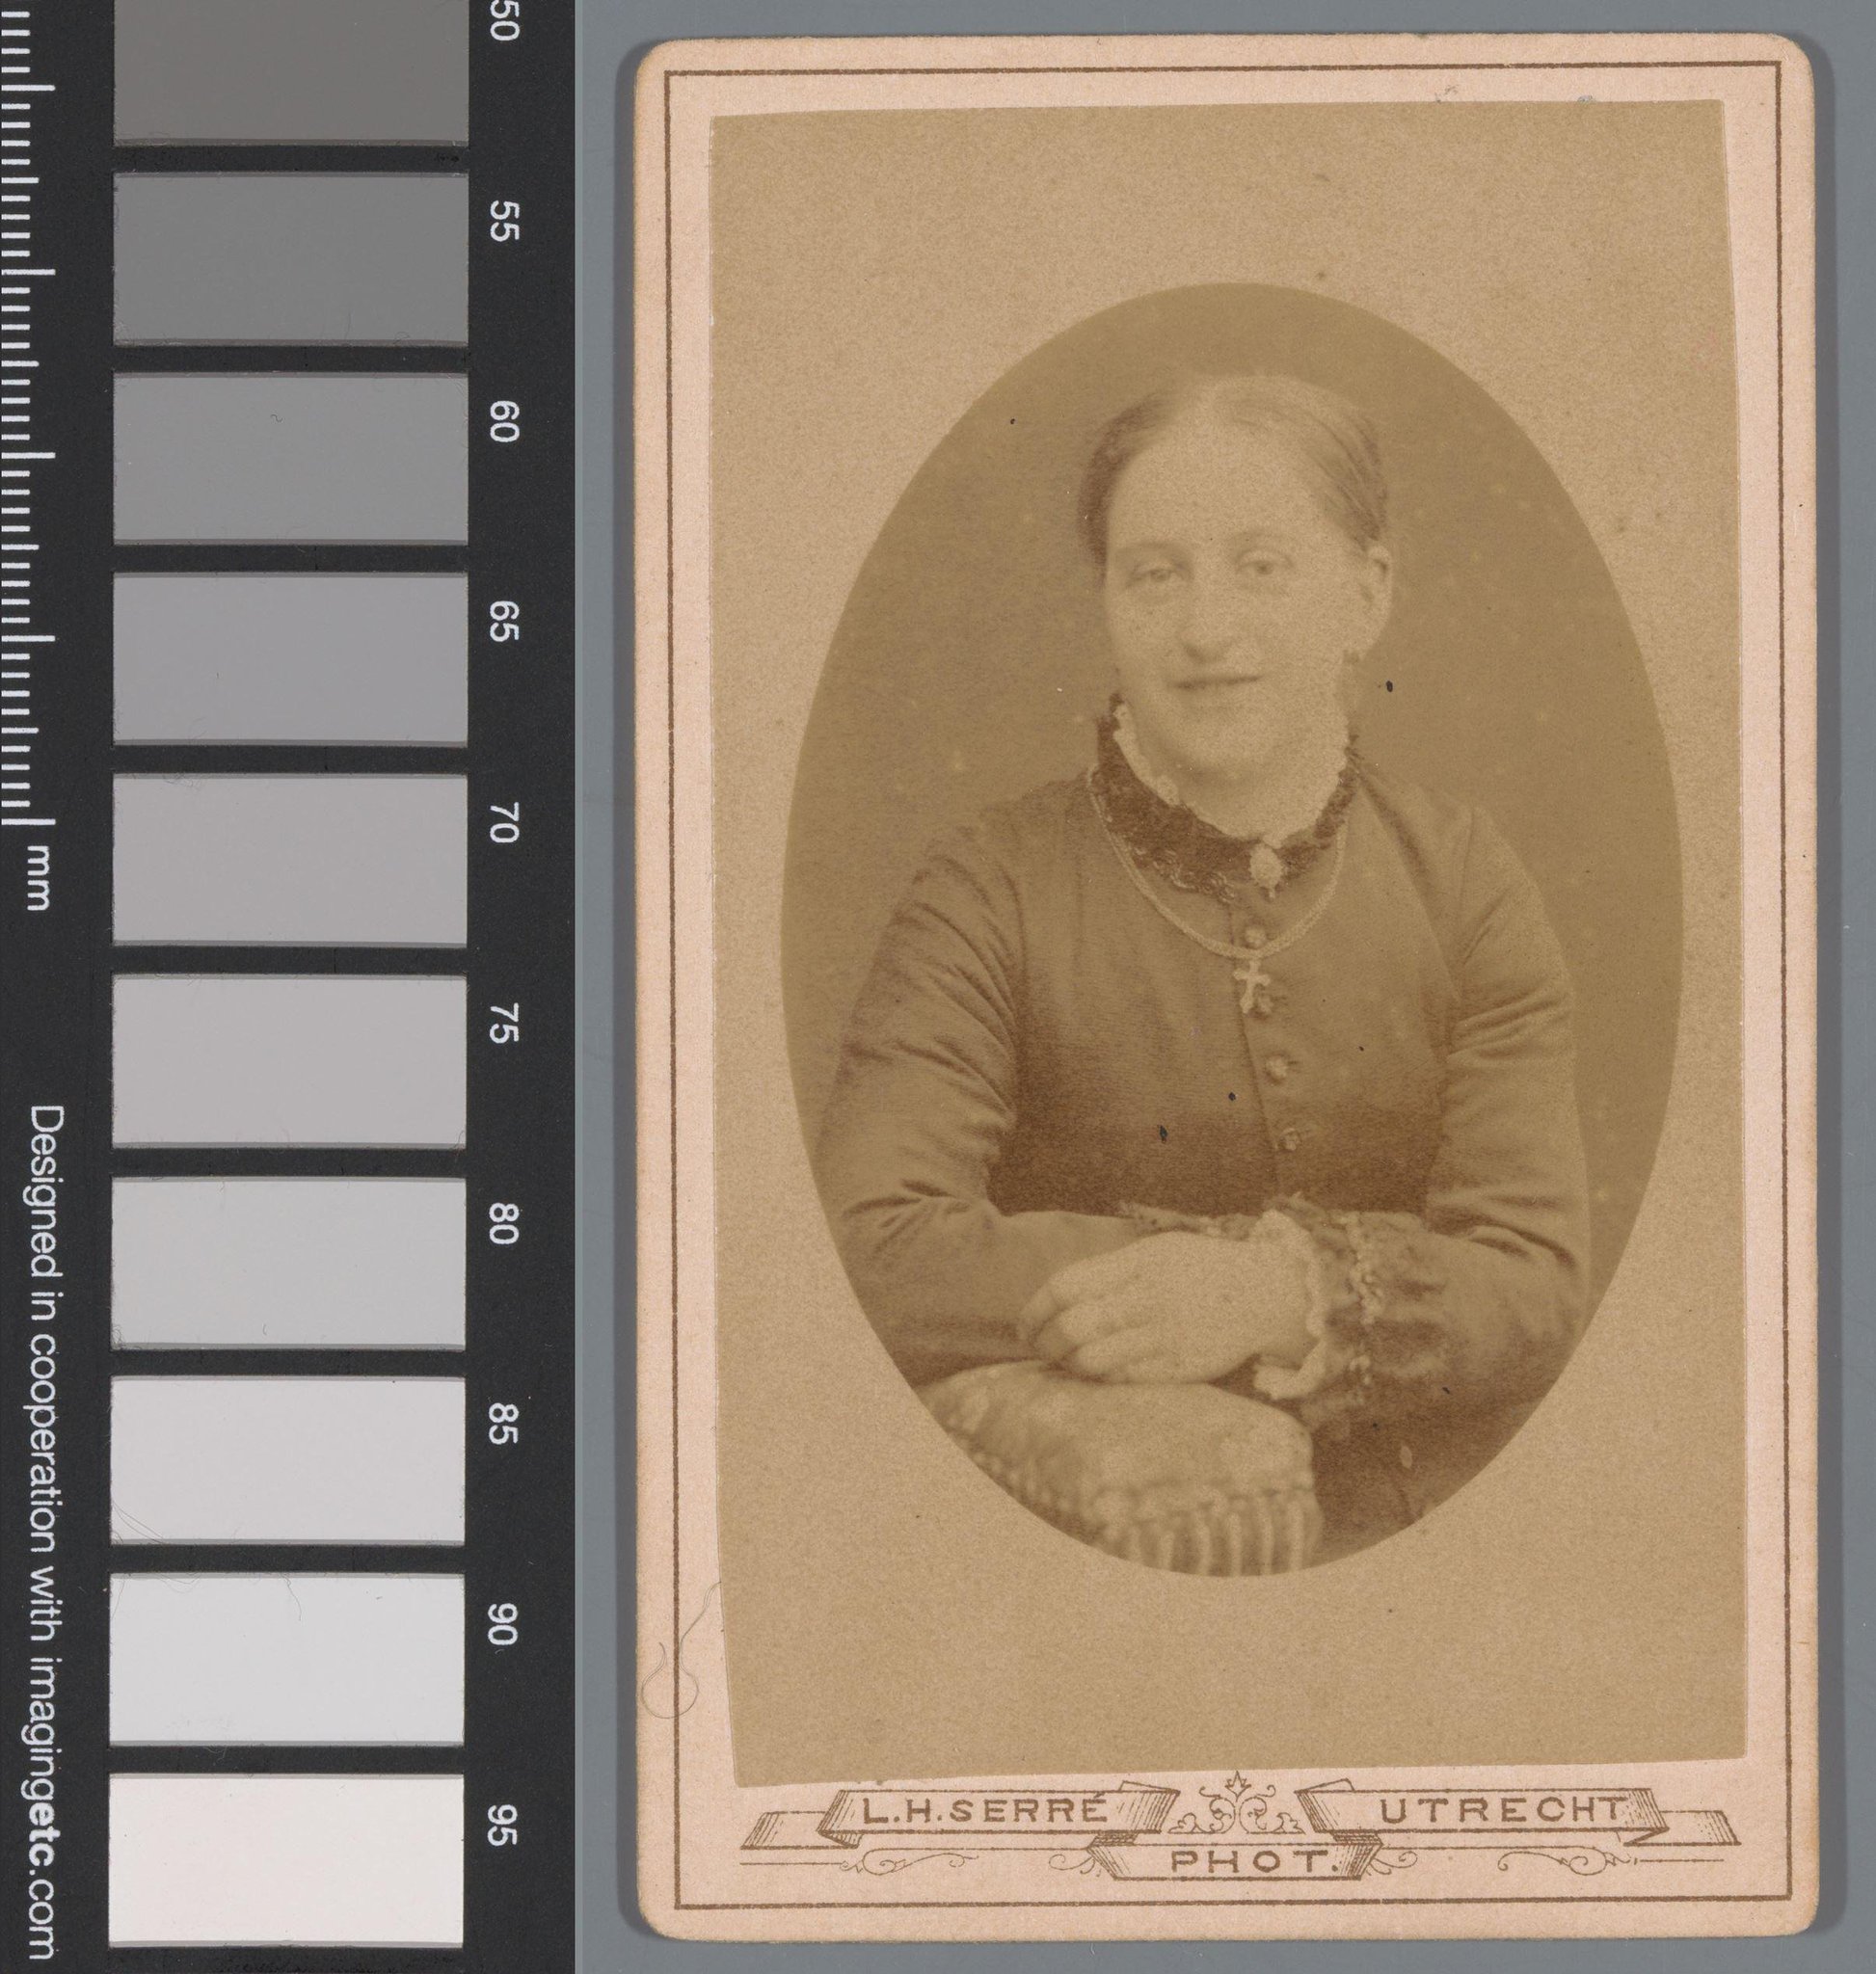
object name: photograph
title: Portret van een onbekende vrouw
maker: lodewijk hendrikus serré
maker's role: fotograaf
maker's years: 1847-1897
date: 1877-1897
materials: cardboard, paper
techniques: albumen print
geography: utrecht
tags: adult woman, anonymous historical person portrayed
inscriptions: address: ‘NACHTEGAALSTRAAT, over het Park Tivoli/ Utrecht/ 's Hage, Tiel en Arnhem.’, inscription: ‘Voor nabestelling blyft de plaat bewaard.’